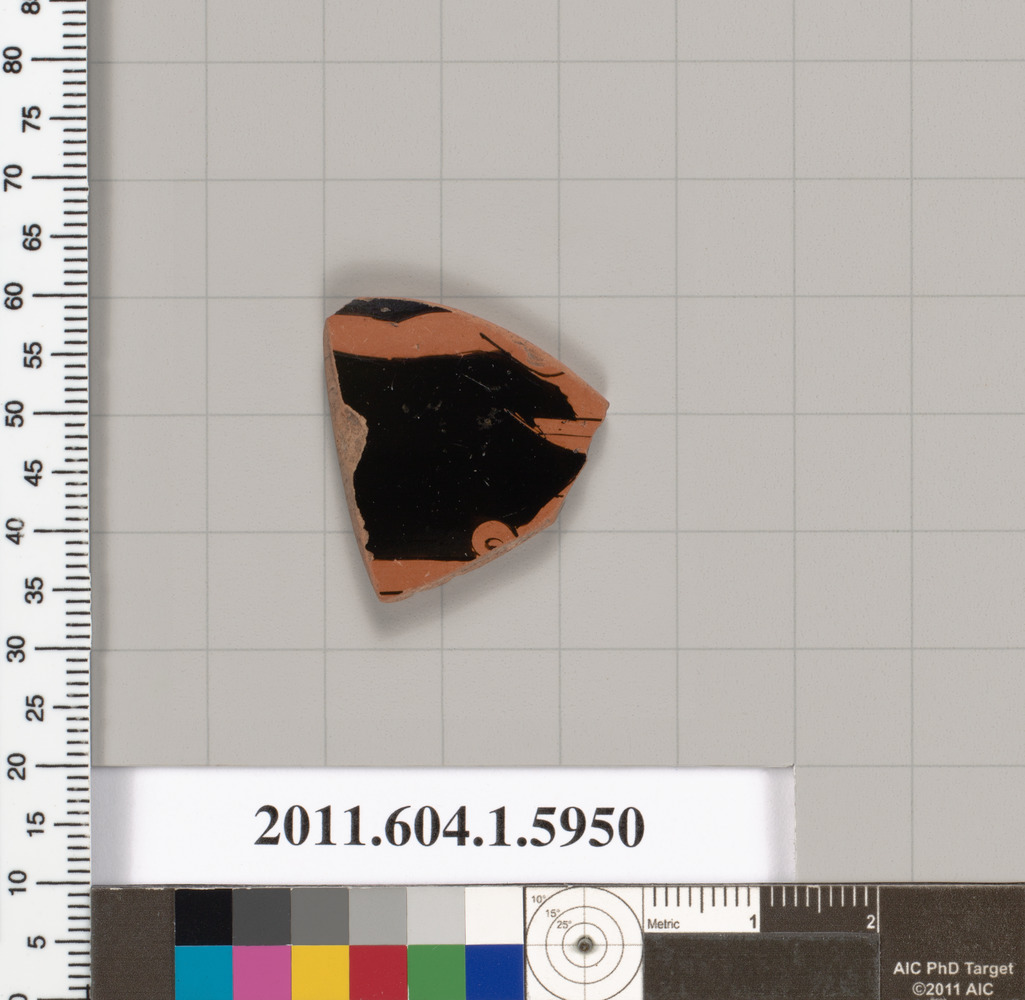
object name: kylix fragment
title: Terracotta fragment of a kylix (drinking cup)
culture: greek, attic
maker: skythes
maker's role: artist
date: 433-567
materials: terracotta